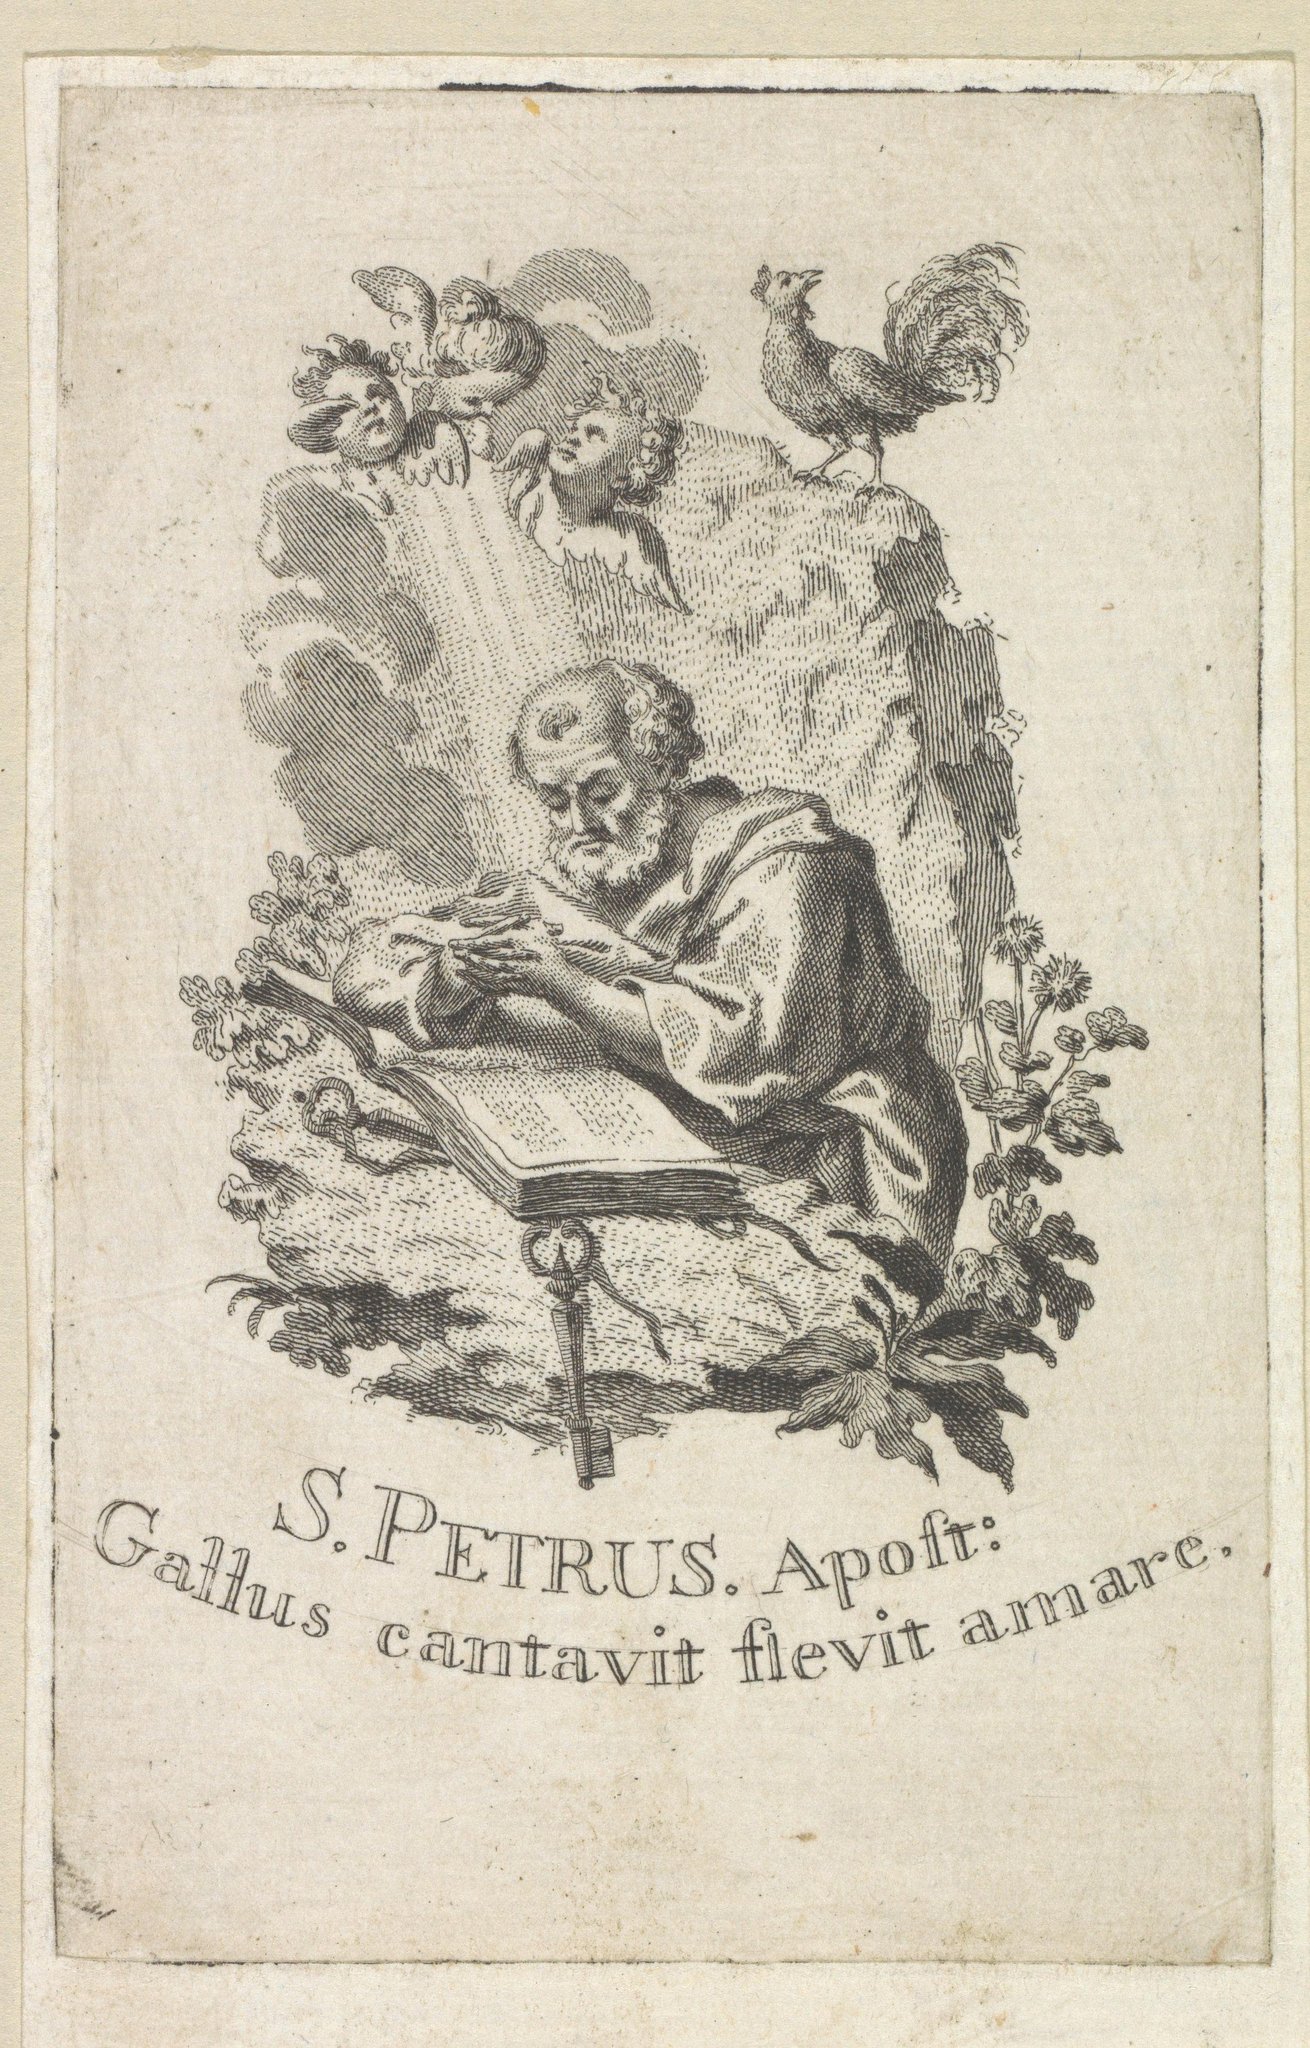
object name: print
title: S. Petrus Apost: / Gattus cantavit flevit amare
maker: giovanni cattini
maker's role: print maker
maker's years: 1725-1800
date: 1735-1800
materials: paper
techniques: etching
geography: italy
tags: the apostle peter, first bishop of rome; possible attributes: book, cock, (upturned) cross, (triple) crozier, fish, key, scroll, ship, tiara - personal devotion of male saint, the apostle peter, first bishop of rome; possible attributes: book, cock, (upturned) cross, (triple) crozier, fish, key, scroll, ship, tiara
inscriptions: collector's mark: Lugt 240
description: De heilige Petrus in gebed. Hij leest in een boek dat voor hem ligt. Voor hem liggen ook twee sleutels. Op de achtergrond een haan op een muurtje. Boven drie cherubijnen.